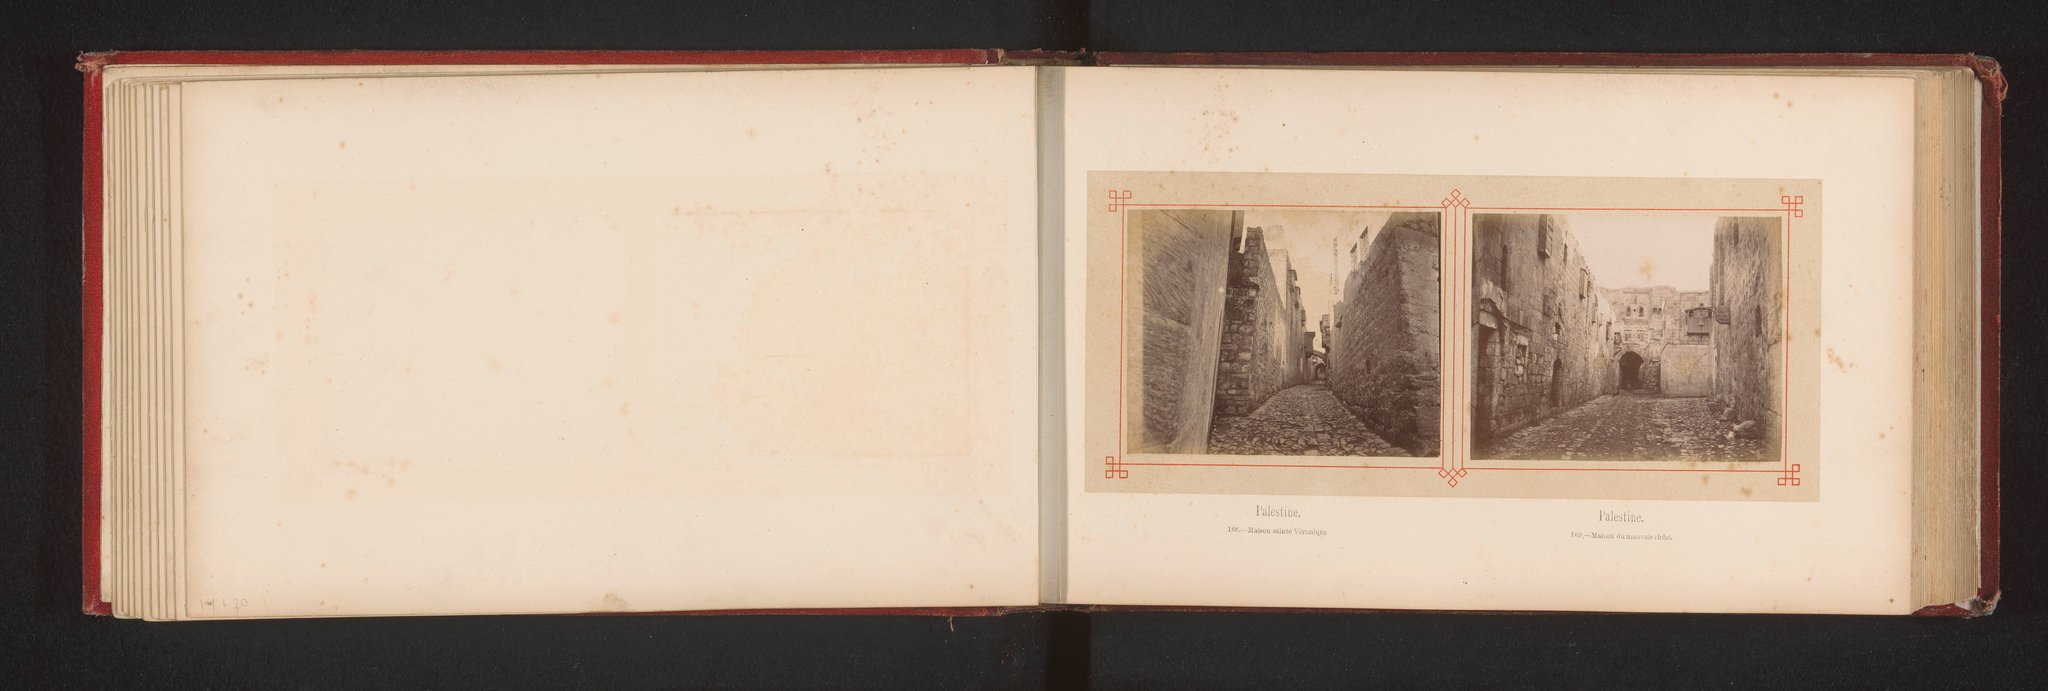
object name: page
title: Palestine - 168. Maison de sainte Veronique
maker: félix bonfils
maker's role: fotograaf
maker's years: 1831-1885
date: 1873-1878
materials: photographic support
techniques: albumen print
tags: lane, alley